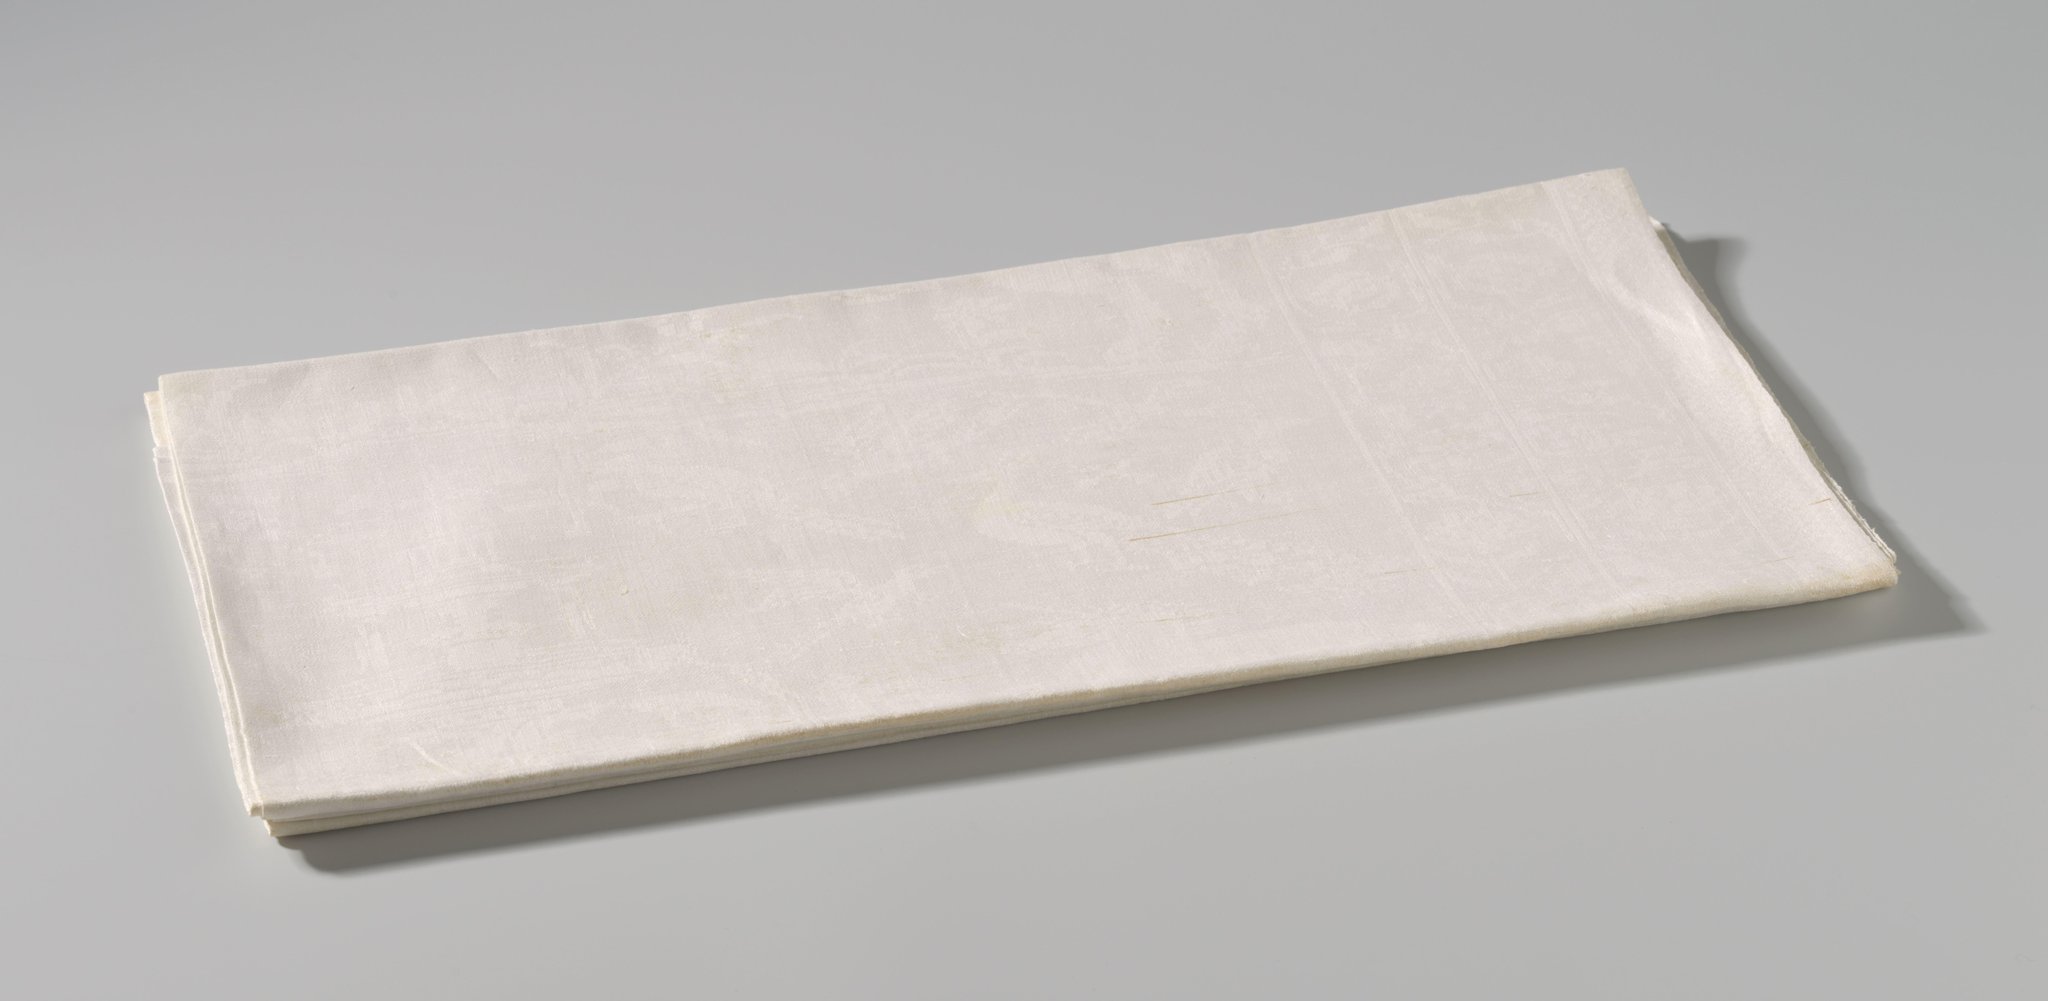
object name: tablecloth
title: Tafellaken met een jachttafereel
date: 1650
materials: linen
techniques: damask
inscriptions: mark: ‘AA 2’